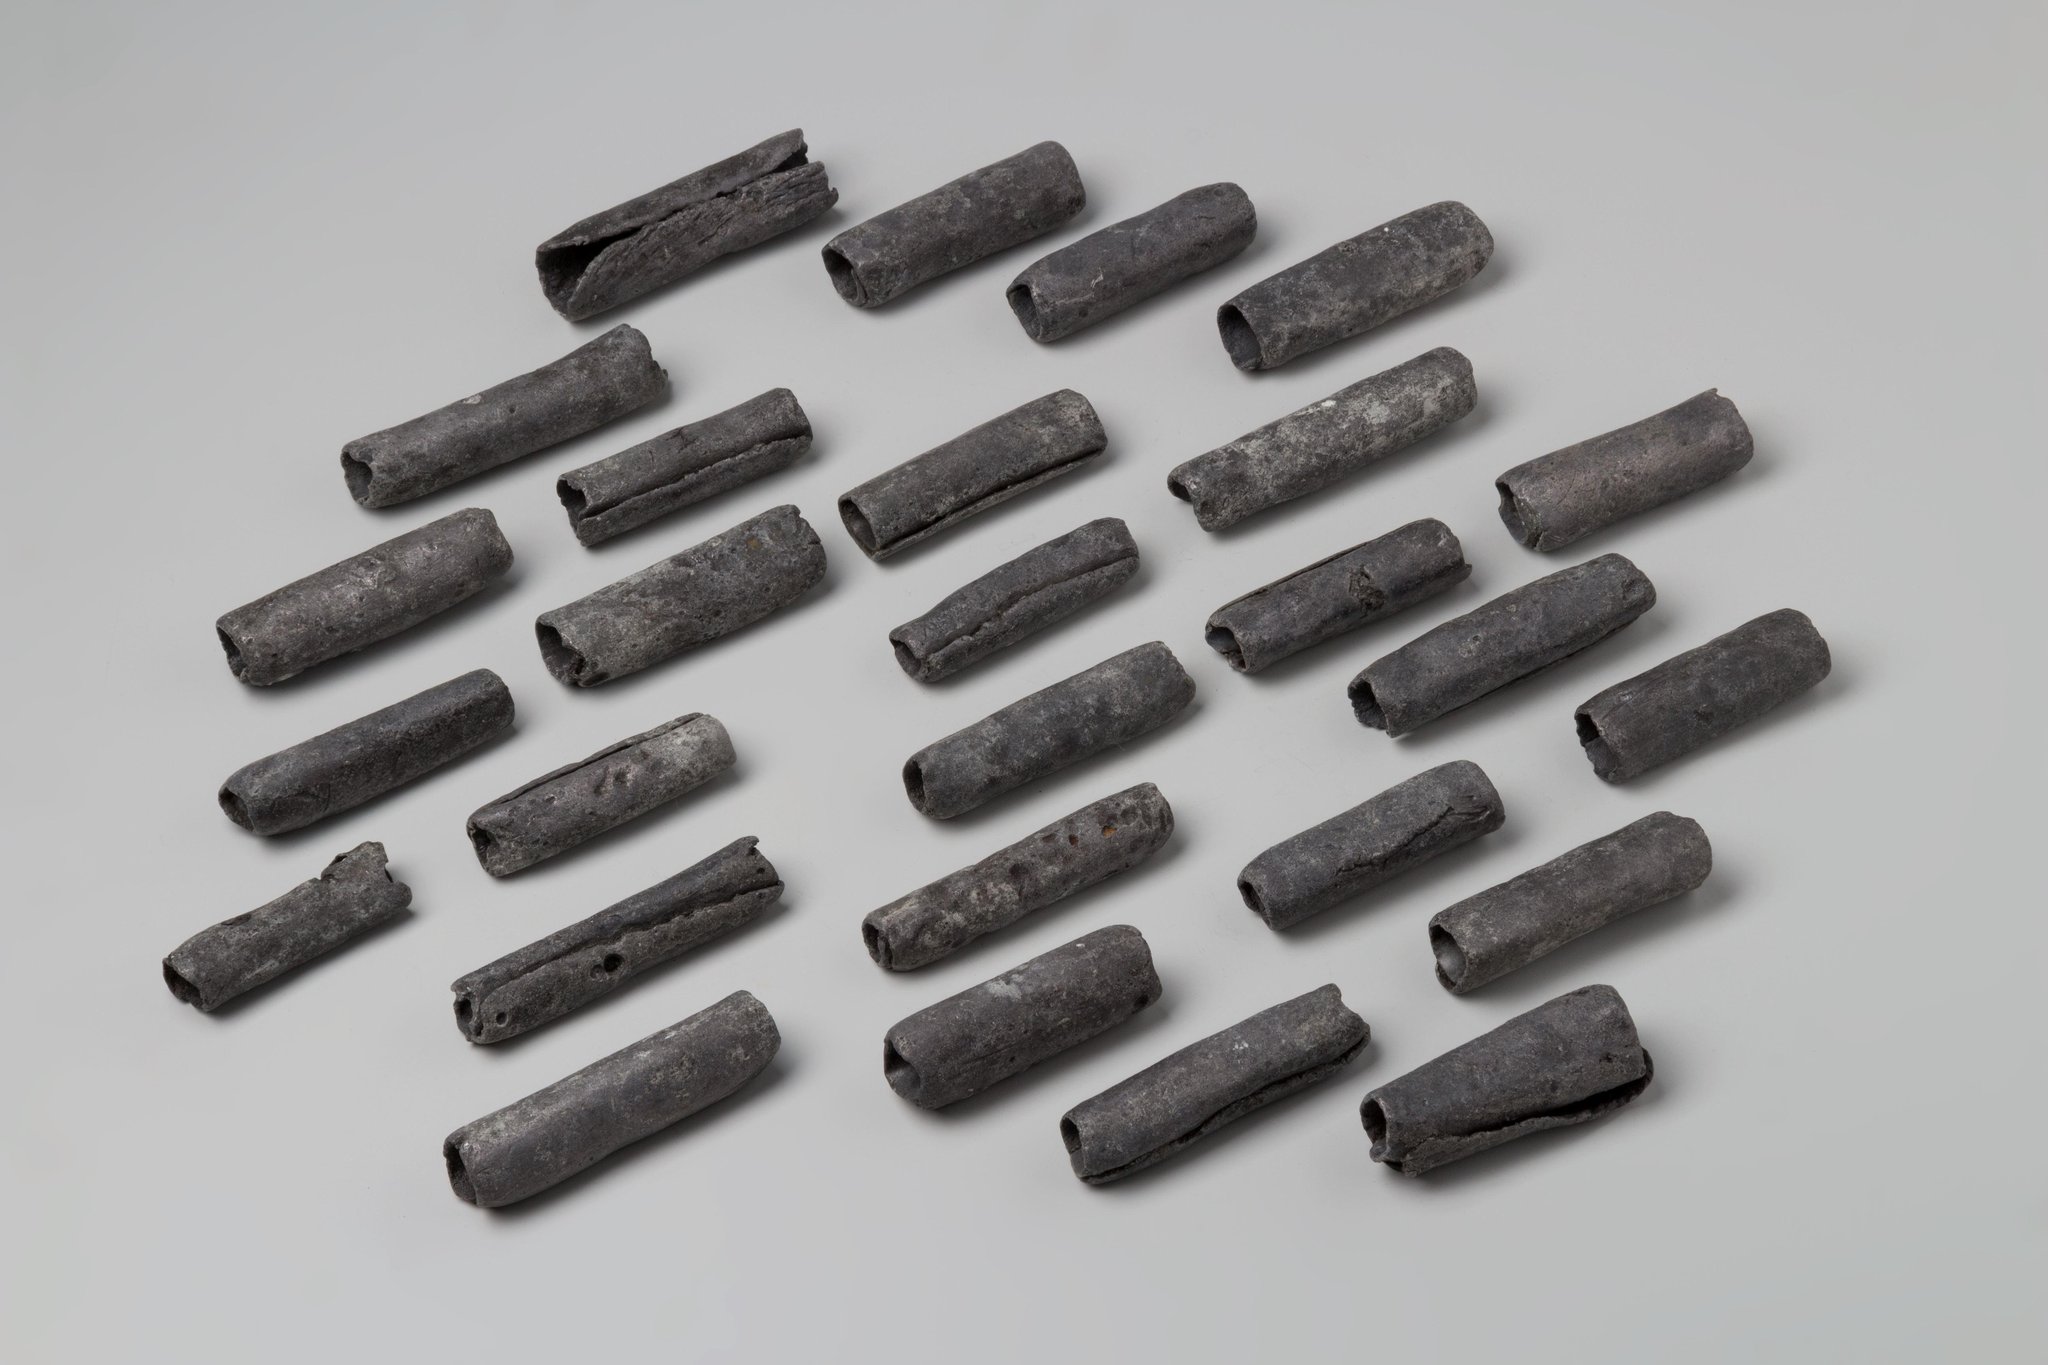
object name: lead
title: Loden rol uit het wrak van de Oost-Indiëvaarder 't Vliegend Hart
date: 1700-1735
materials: lead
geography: middelburg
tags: 't vliegend hart (schip), verenigde oostindische compagnie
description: Deze loden buisjes zijn vermoedelijk afkomstig van visnetten ofwel op TVliegend Hart zelf ofwel van vissers die hun netten aan het wrak verloren.